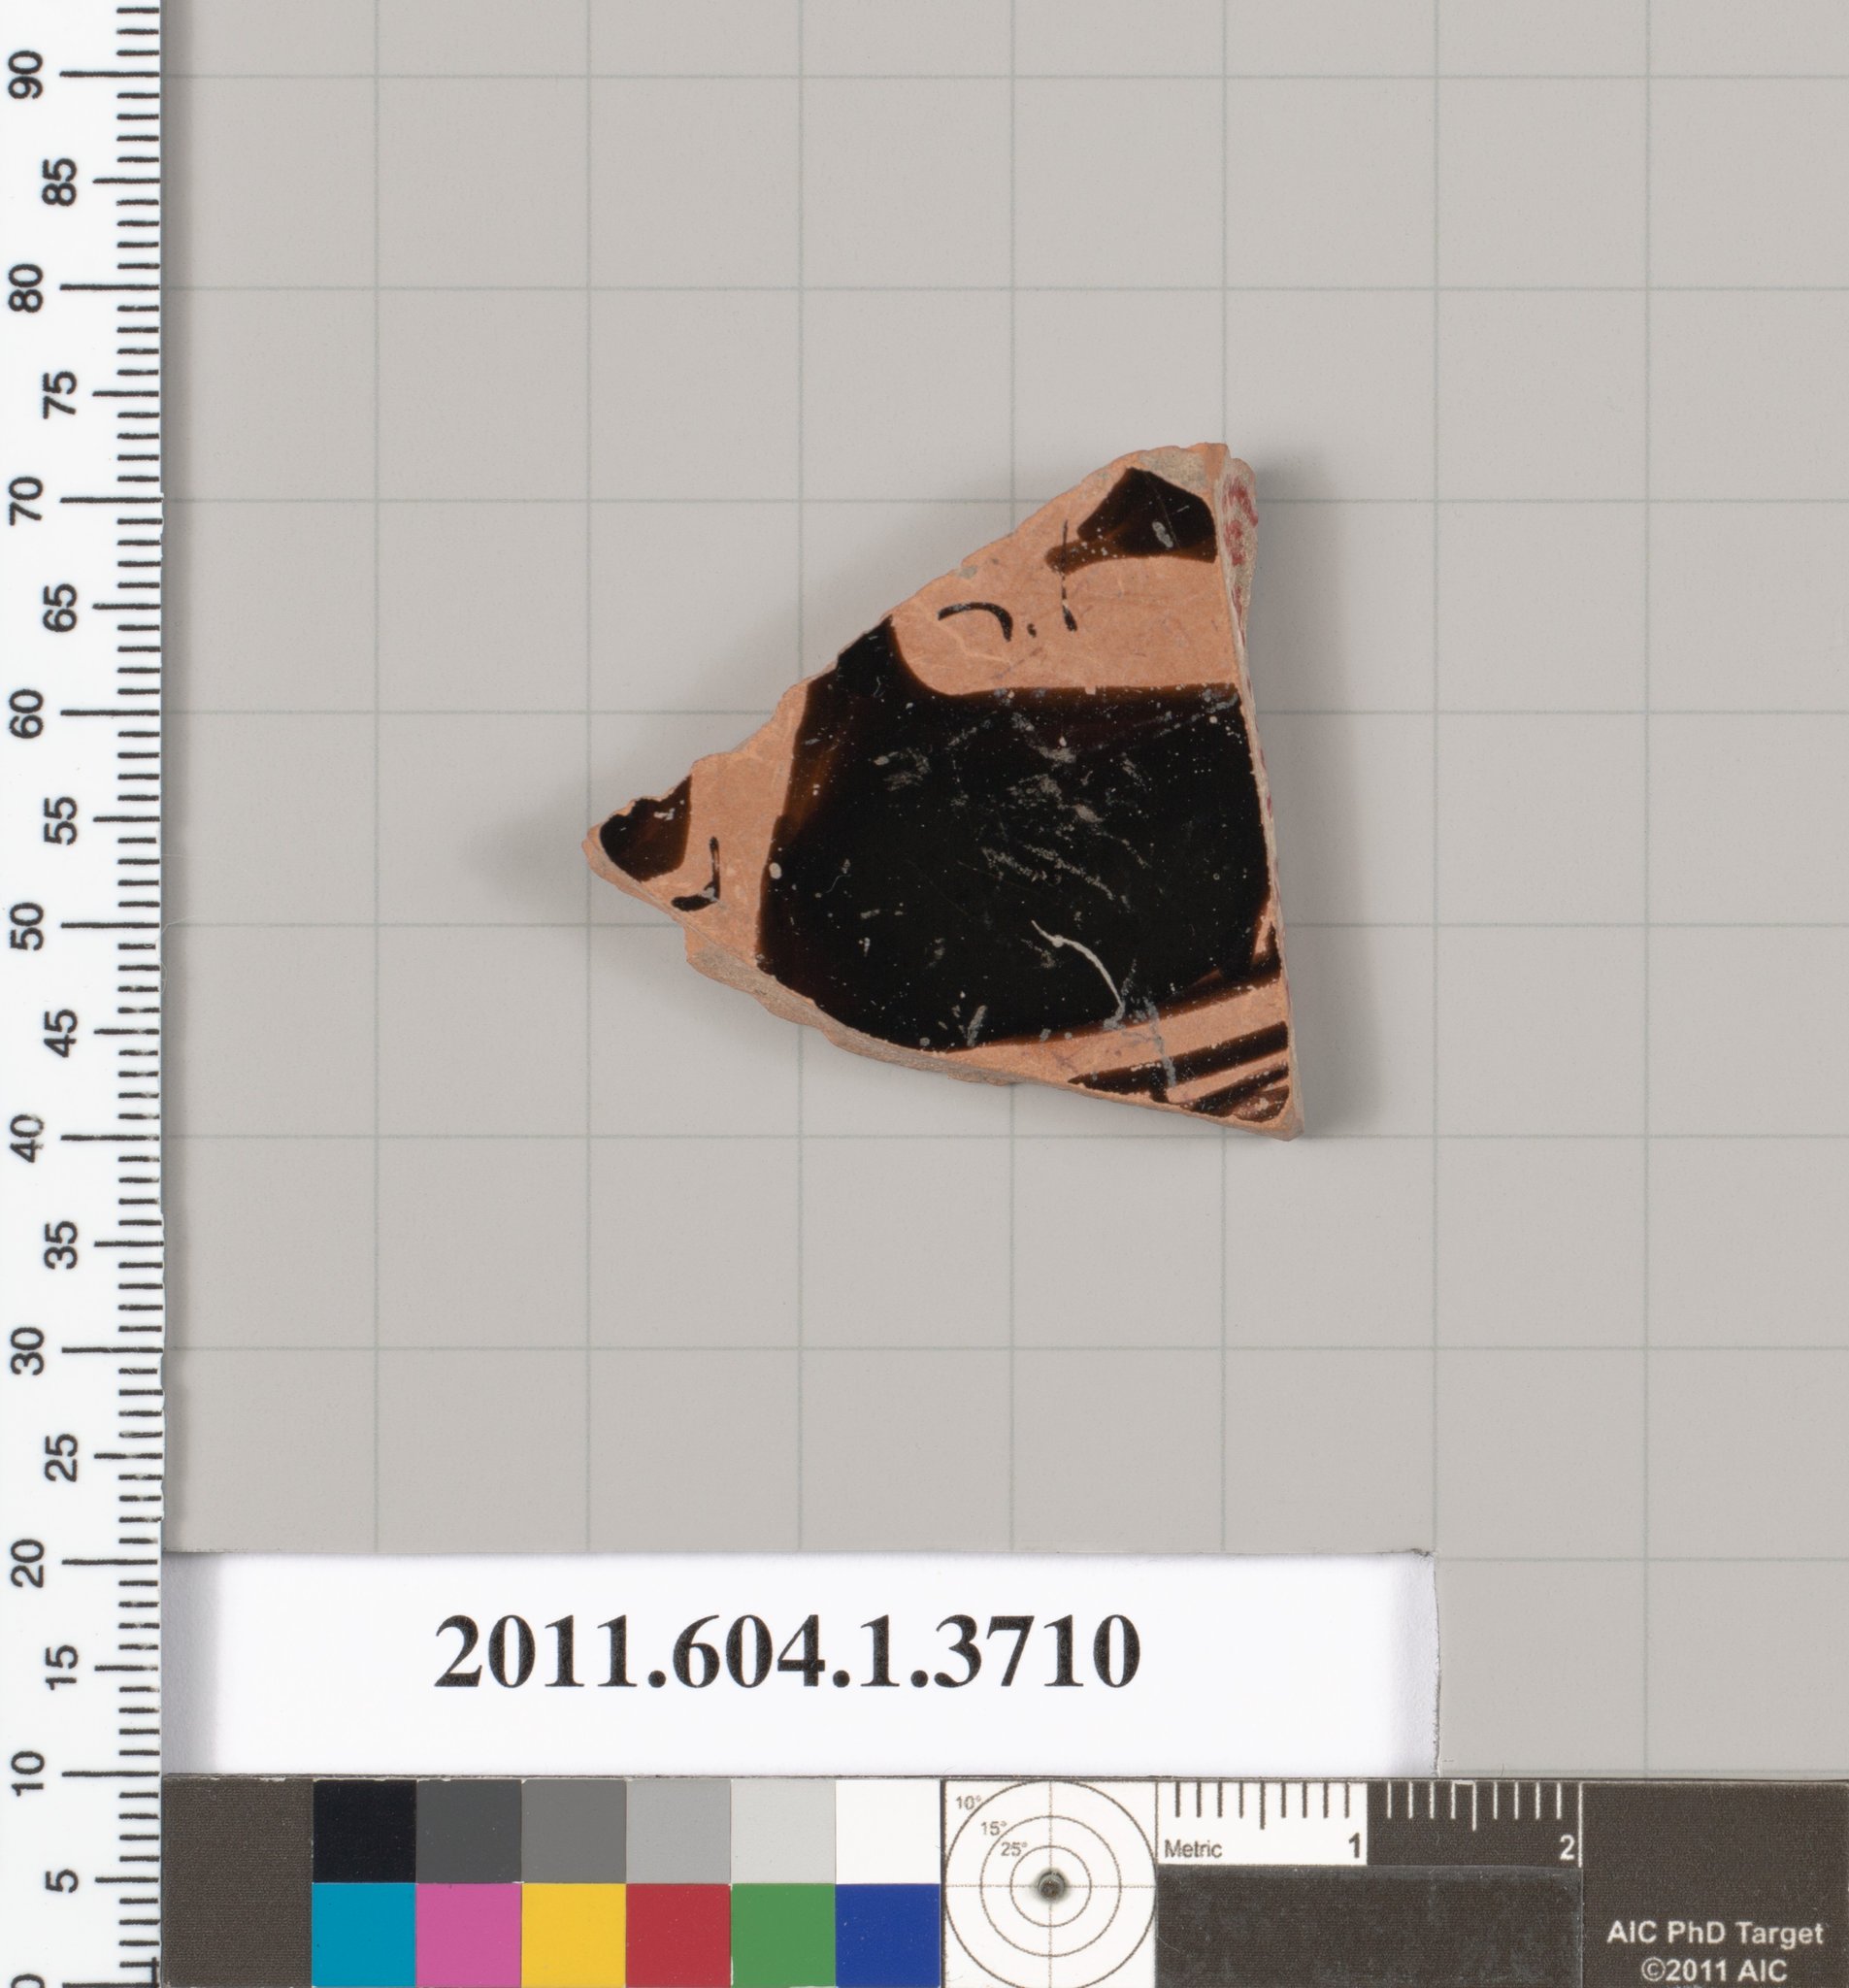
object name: kylix fragment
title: Terracotta fragment of a kylix (drinking cup)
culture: greek, attic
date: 475-451 BCE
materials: terracotta